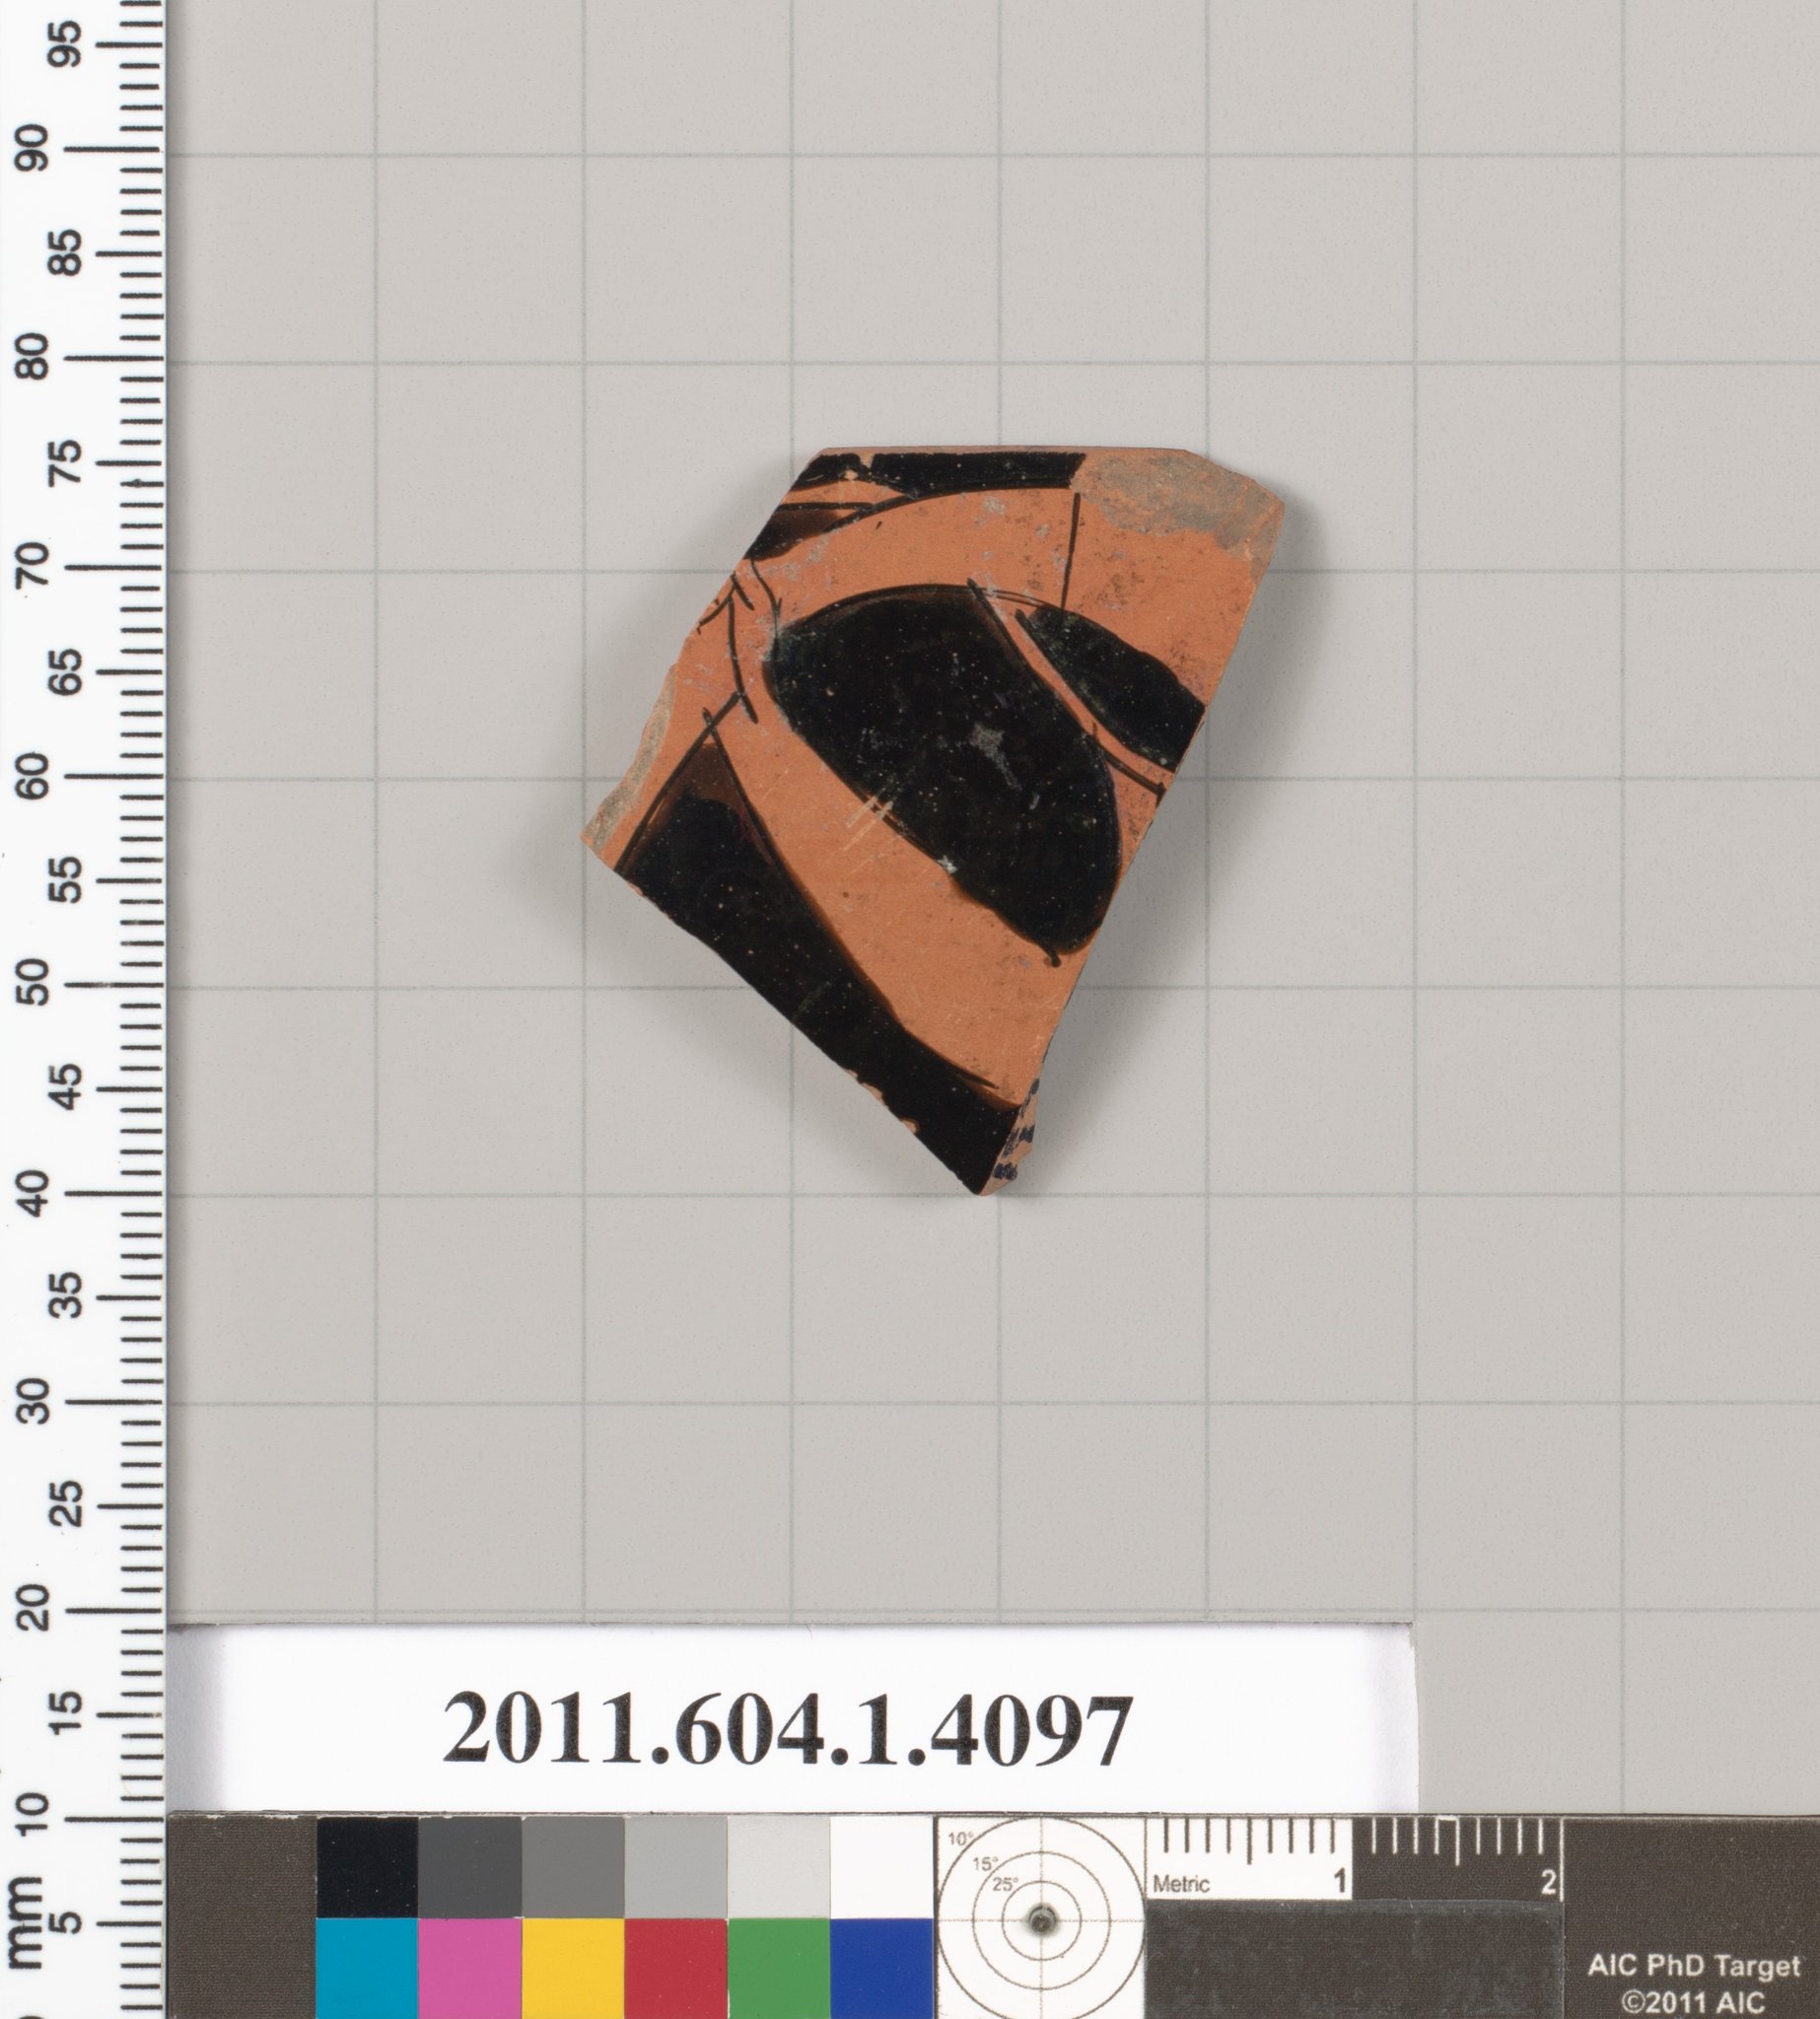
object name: kylix fragment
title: Terracotta rim fragment of a kylix (drinking cup)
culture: greek, attic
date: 520-500 BCE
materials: terracotta